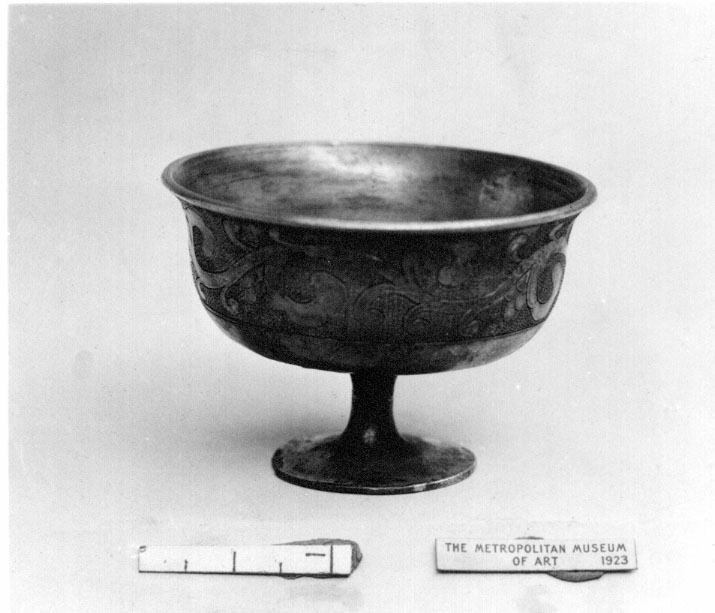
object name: stem cup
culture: chinese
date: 601-800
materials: silver